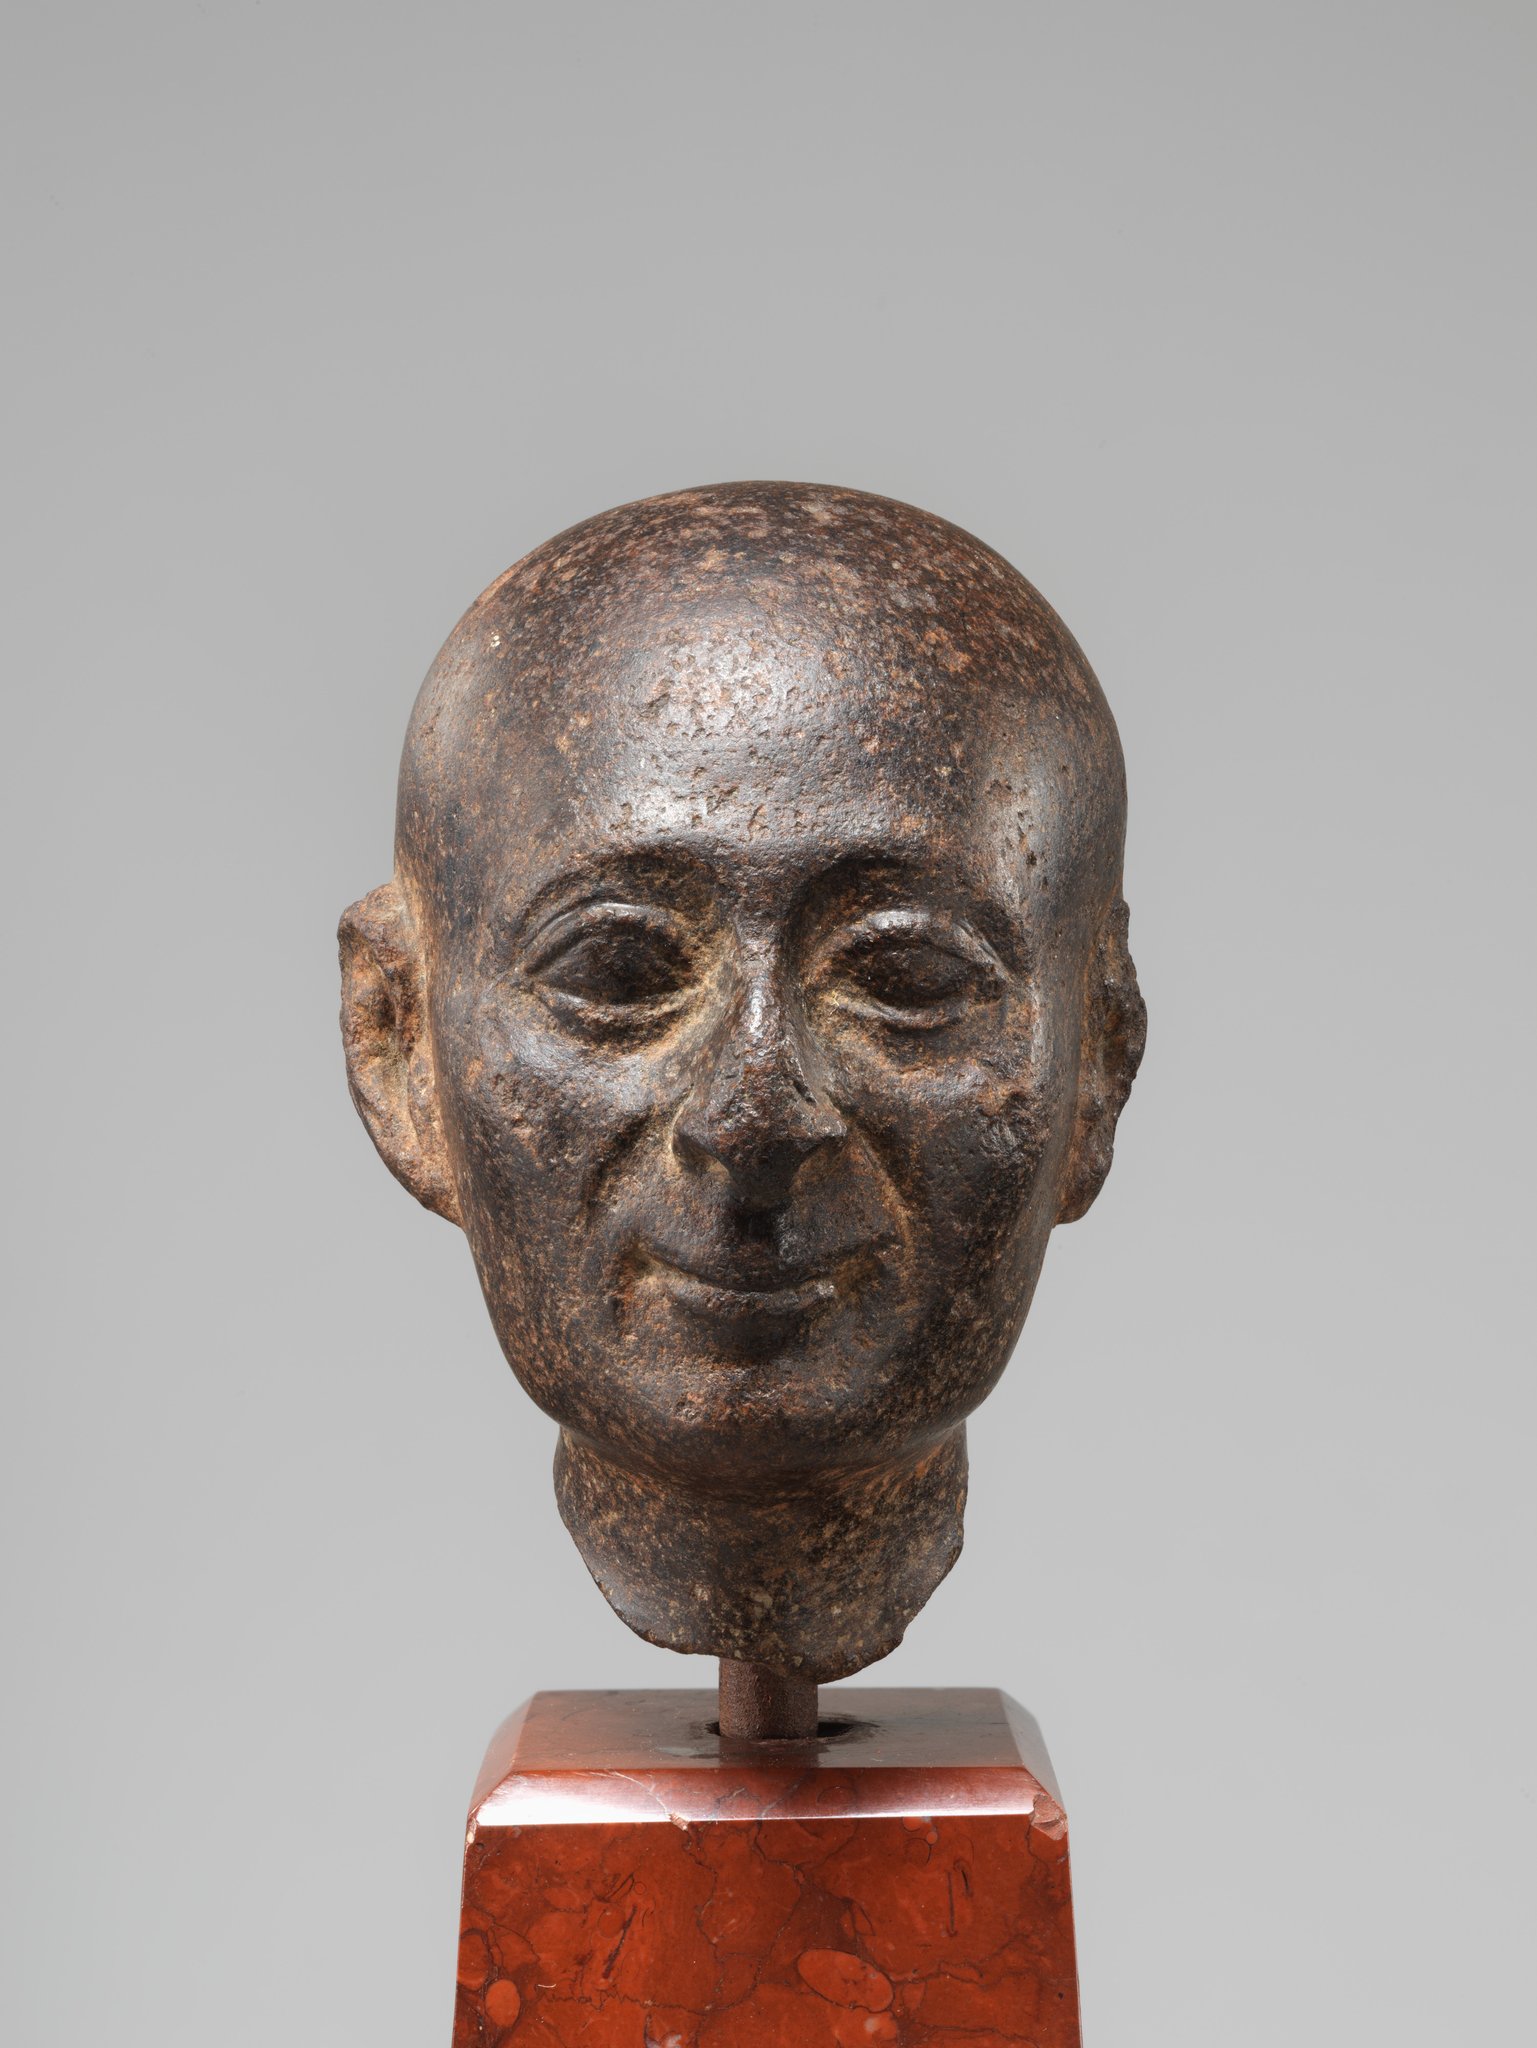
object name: head of a man with a shaved head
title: Man with a Shaved Head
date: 301-400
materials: stone, quartzite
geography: egypt